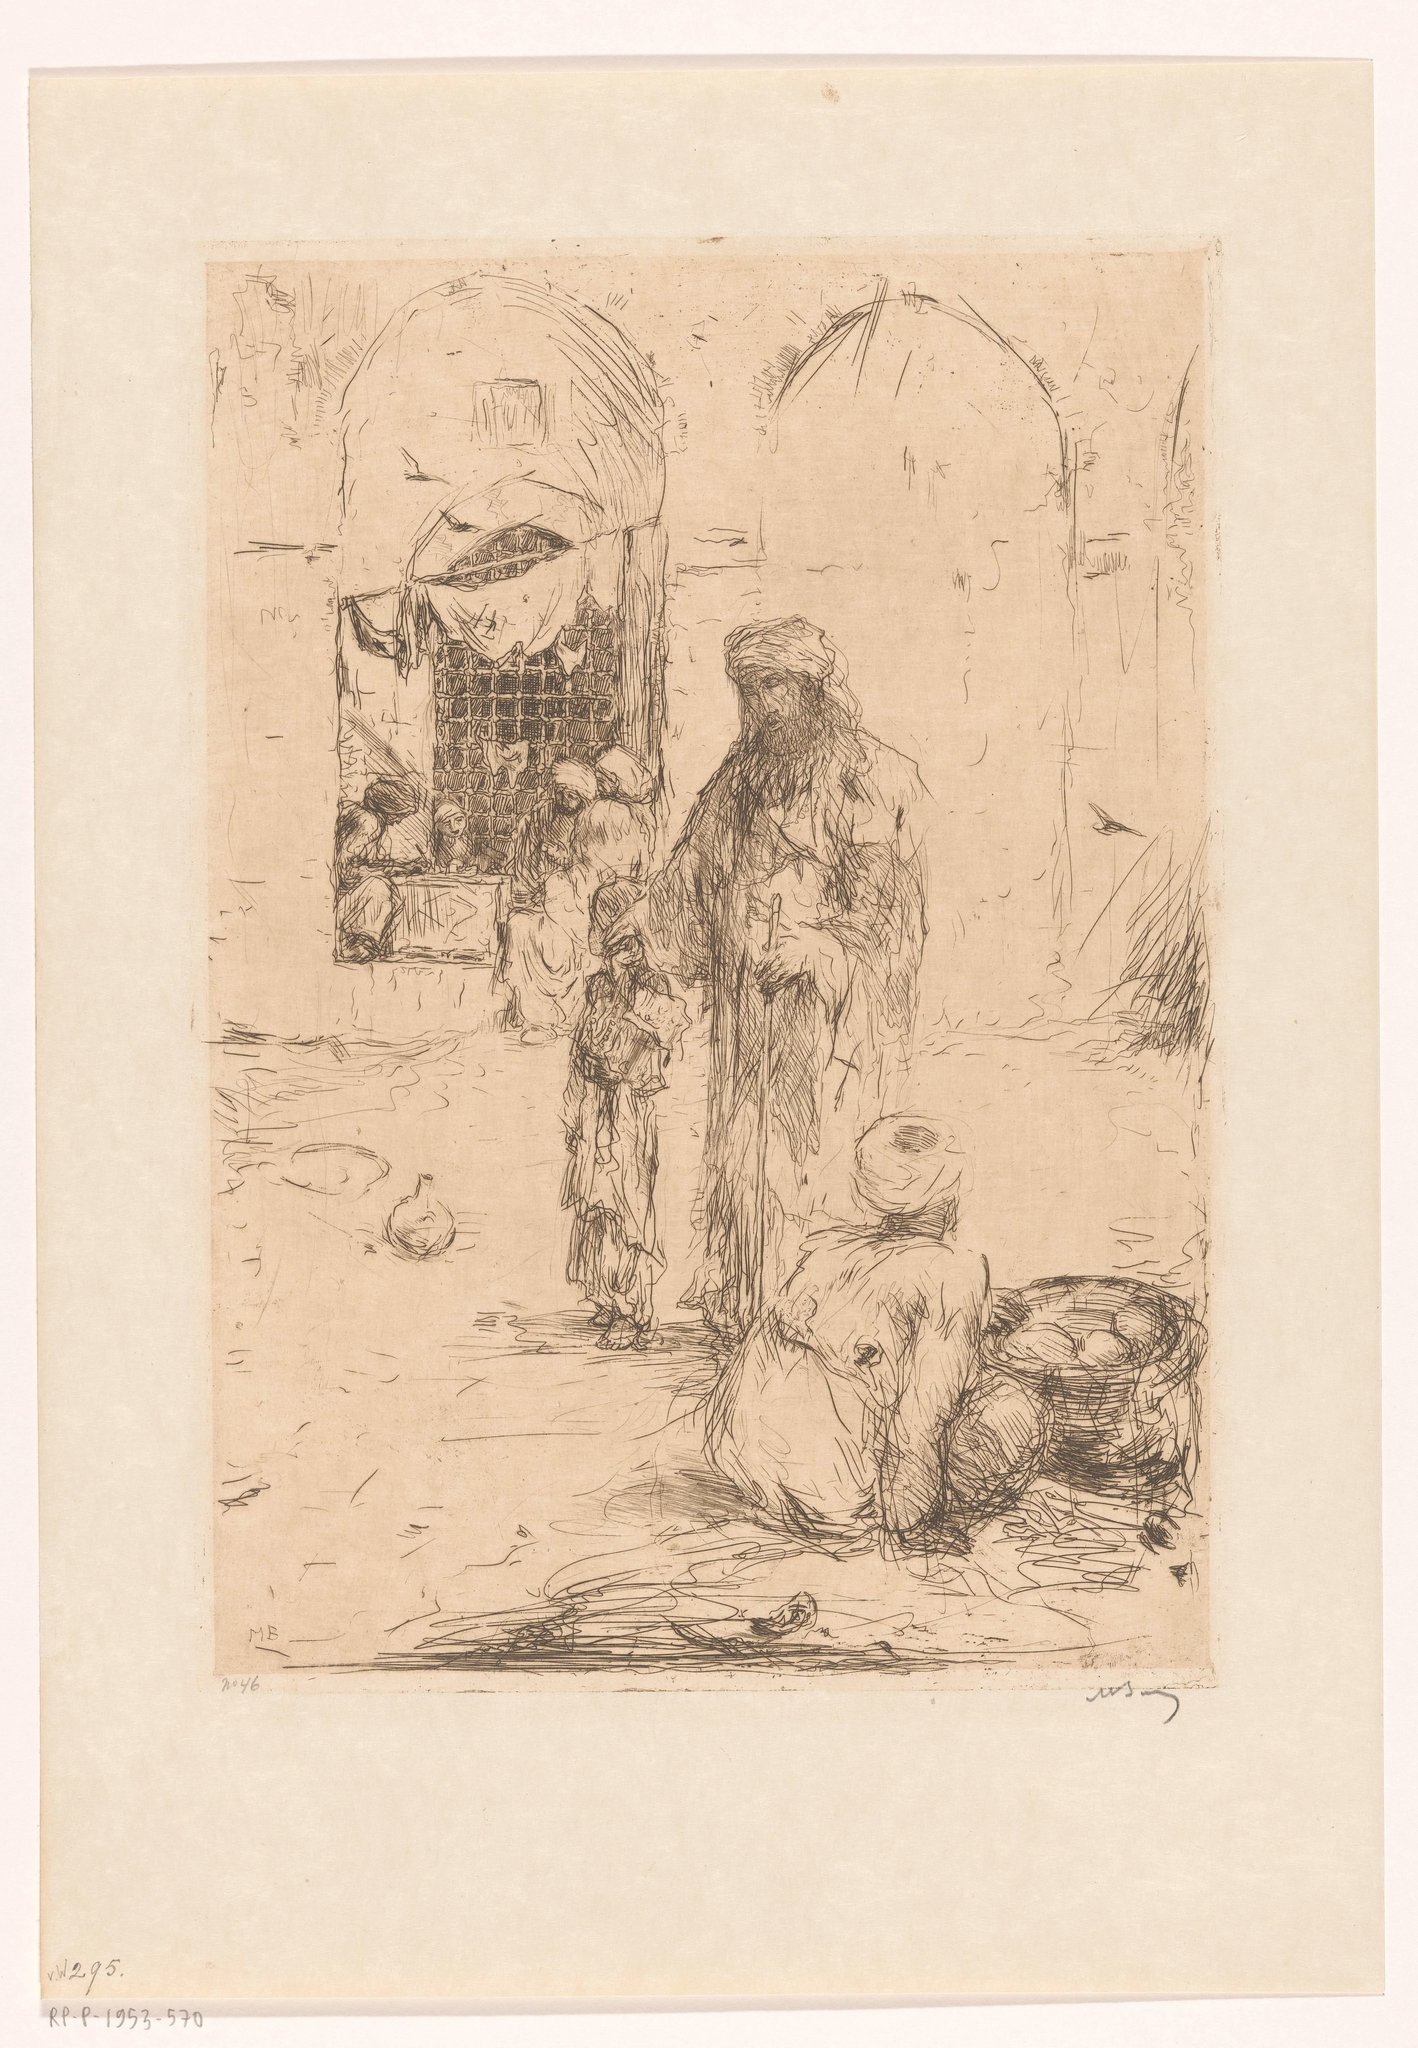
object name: print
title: Blinde bedelaar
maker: marius bauer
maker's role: draughtsman, print maker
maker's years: 1867-1932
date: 1933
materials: paper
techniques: etching, intaglio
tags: blind, blindness, beggar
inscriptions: collector's mark: Lugt 2228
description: Een man in oosterse kleding loopt met een stok in zijn linkerhand over straat. Zijn rechterhand wordt door een jongen vastgehouden. Rechts op de voorgrond een zittende man bij een mand. Op de achtergrond vier mannen bij een portaal.